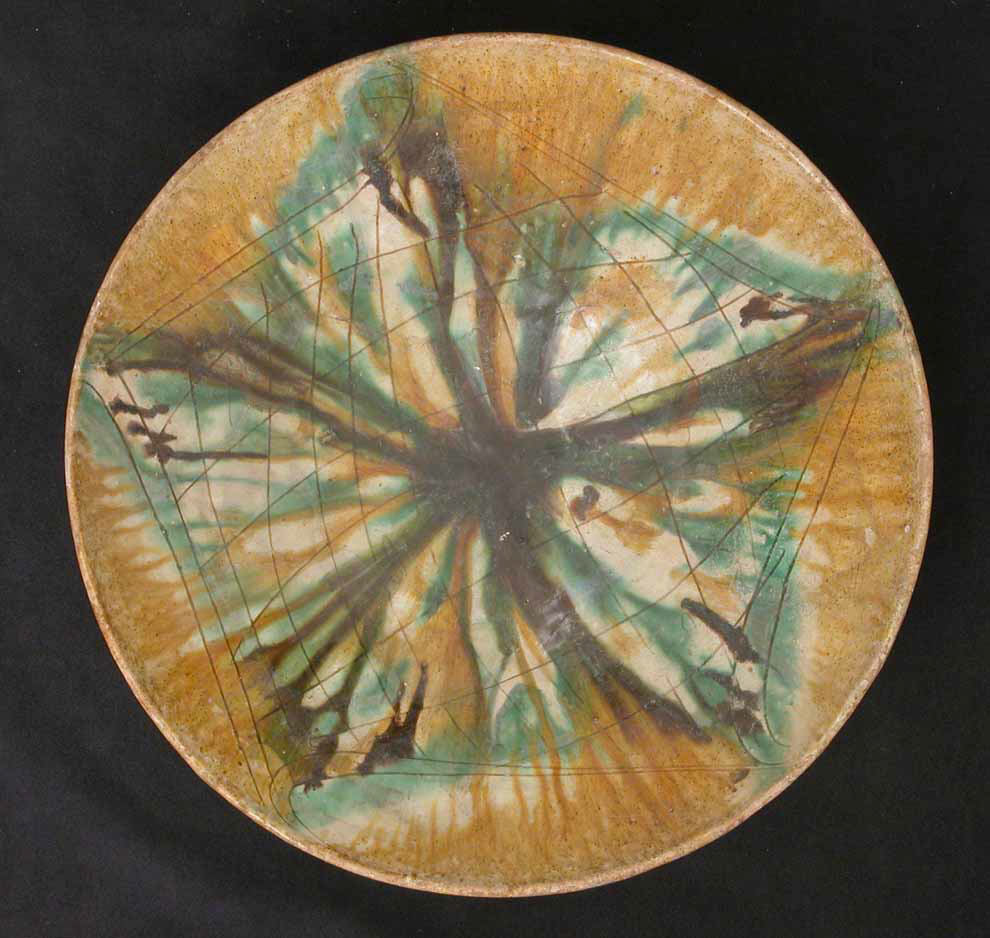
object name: bowl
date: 901-1000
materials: earthenware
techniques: glazing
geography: uzbekistan